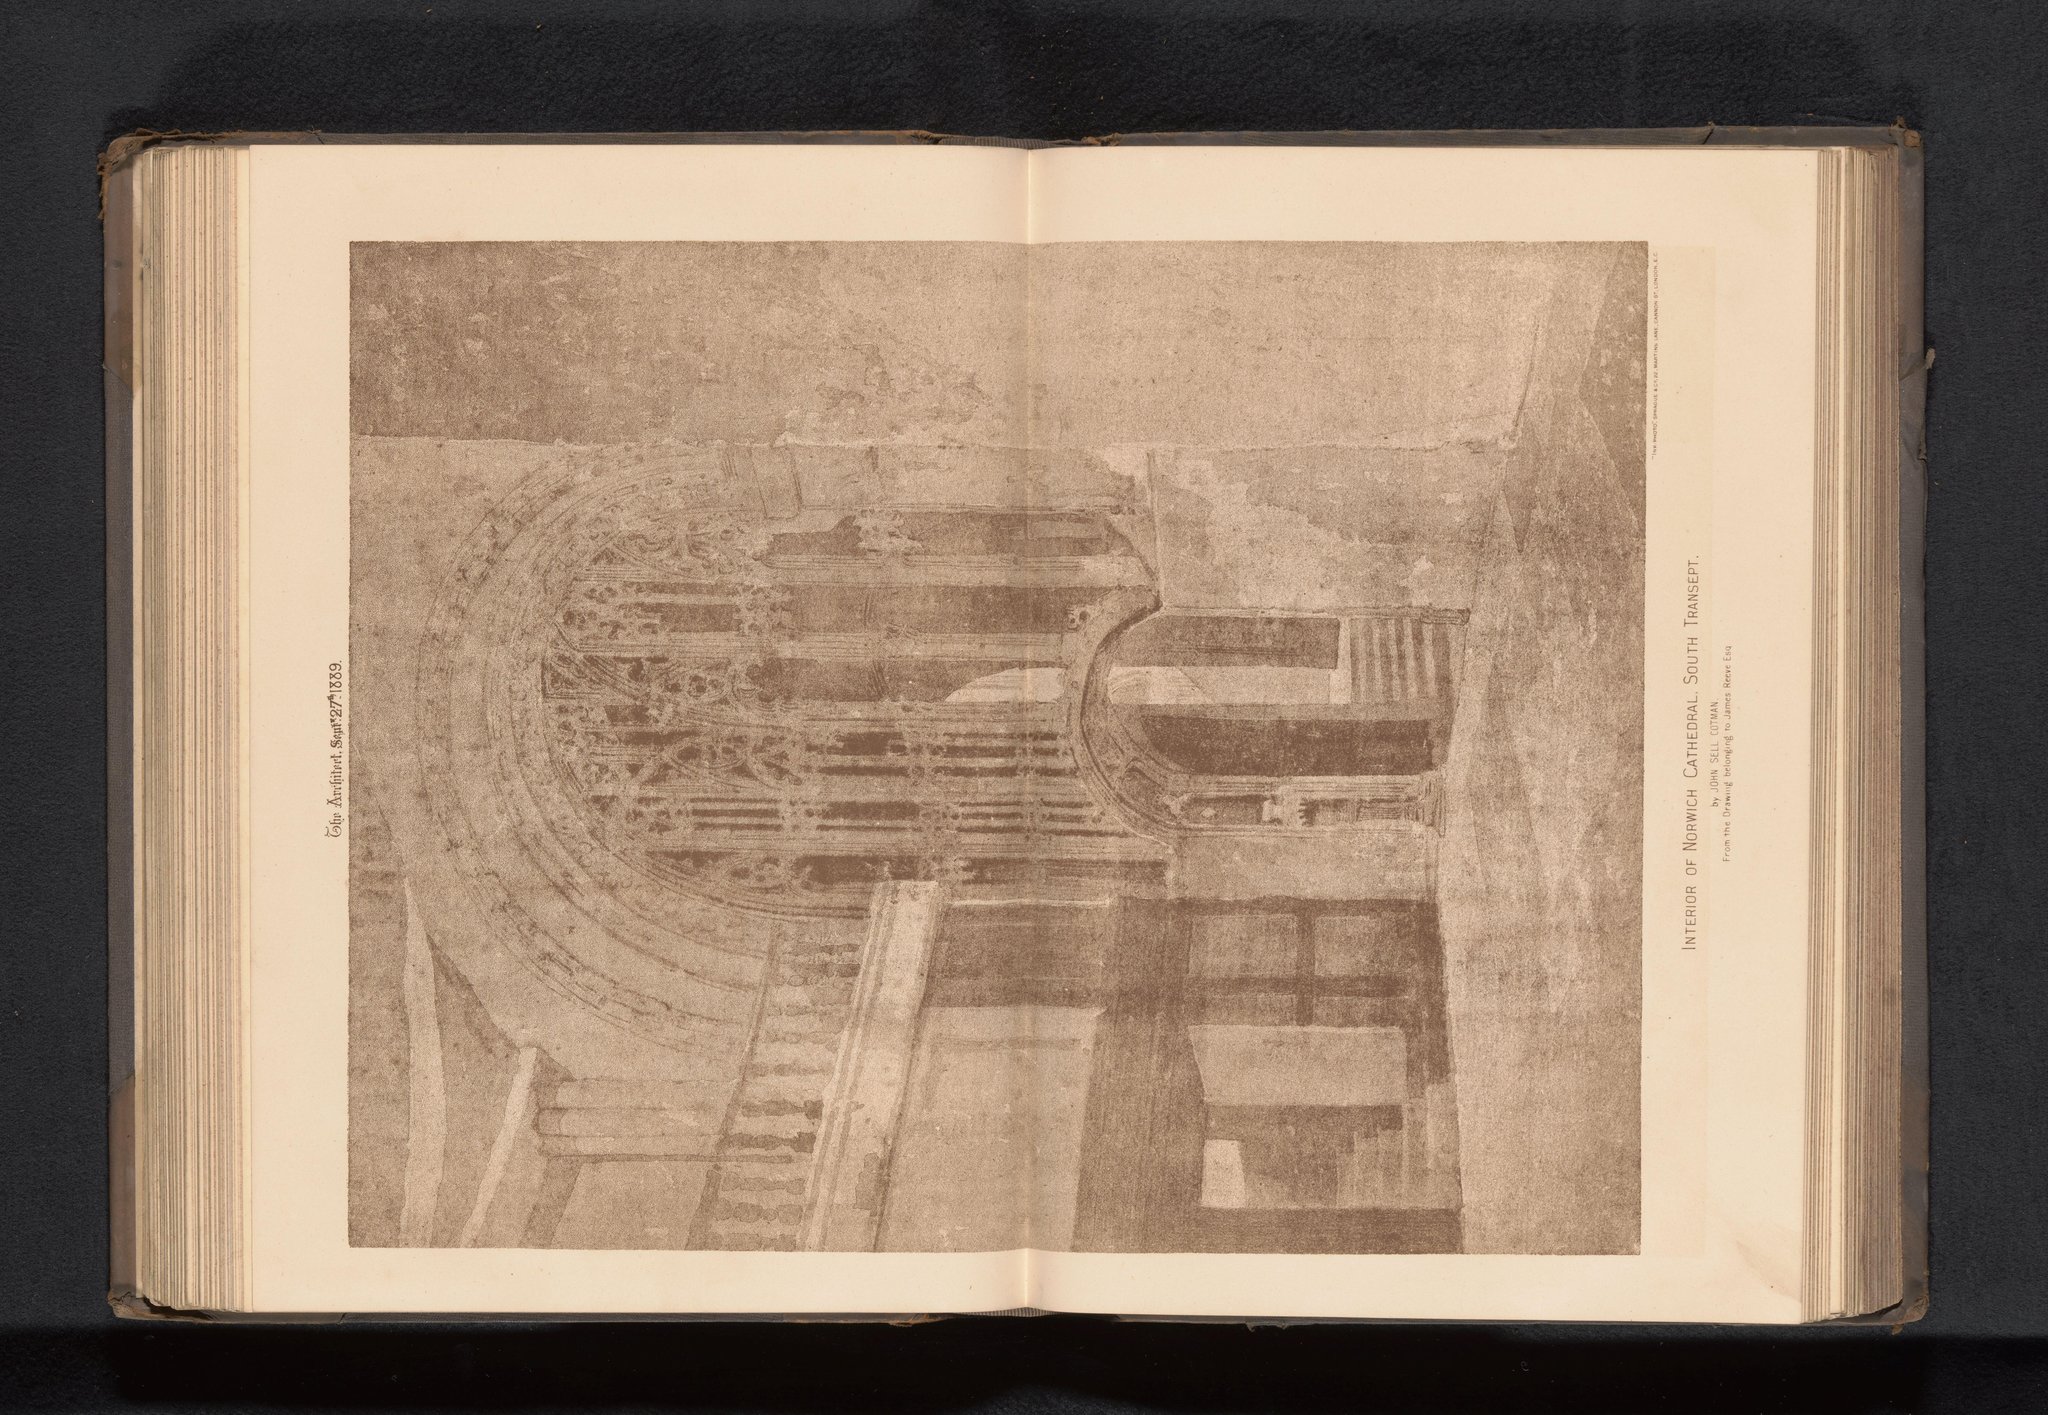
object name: photomechanical print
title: Reproductie van een tekening van het interieur van de kathedraal te Norwich door John Sell Cotman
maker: john sell cotman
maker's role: draughtsman, print maker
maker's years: 1782-1842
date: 1884-1889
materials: paper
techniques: photolithography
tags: designing, sketching ~ architect, interior of church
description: Prent op tweede ongenummerde pagina na pagina 178.